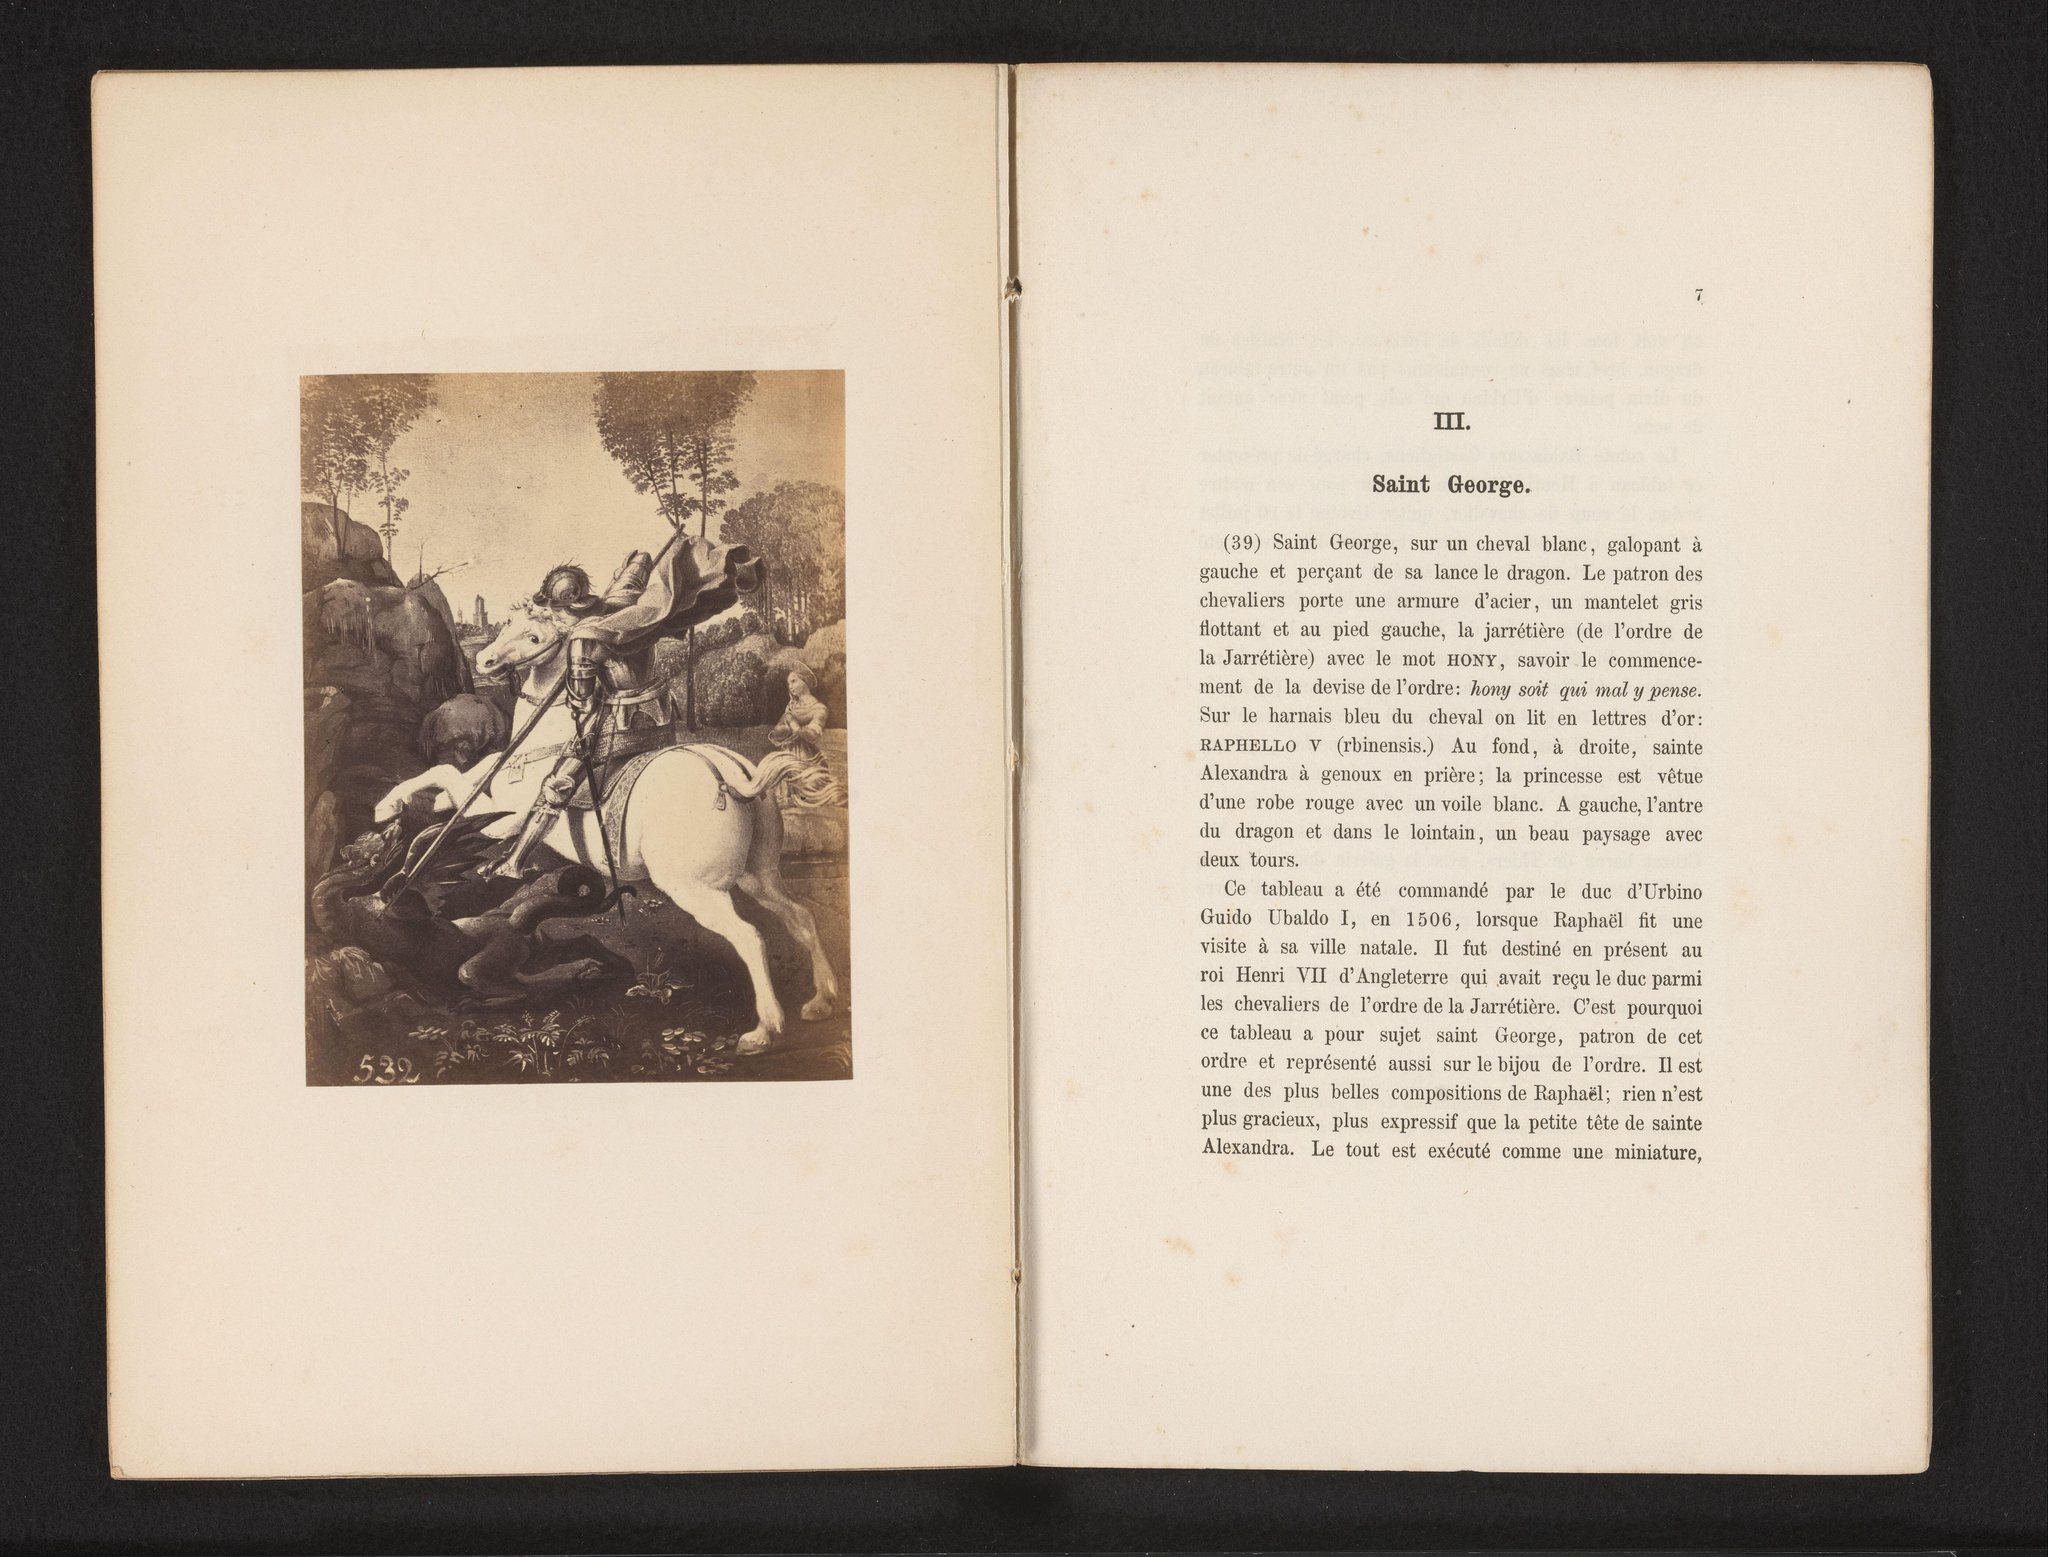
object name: page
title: Fotoreproductie van het schilderij Saint George door Rafaël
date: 1861-1866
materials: paper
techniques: albumen print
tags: picture, painting, the warrior martyr george (georgius); possible attributes: banner (red cross on white field), (red) cross, dragon, (white) horse, broken lance, shield (with cross), sword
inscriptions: number: ‘532’